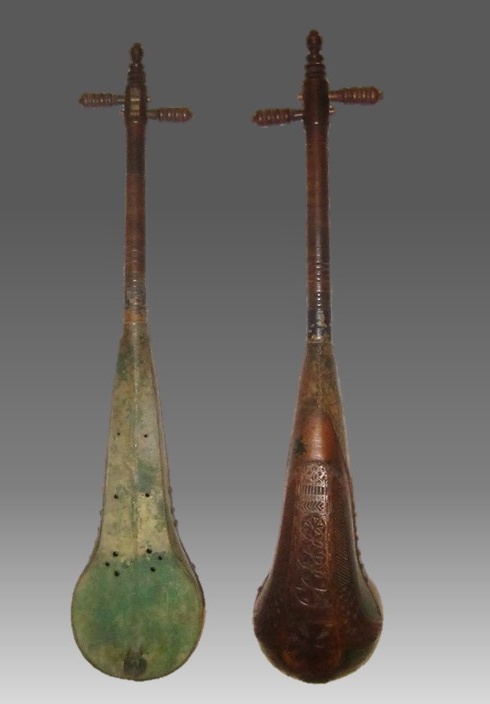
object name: gunibri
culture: egyptian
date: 1801-1900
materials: horn, metal, wood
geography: egypt